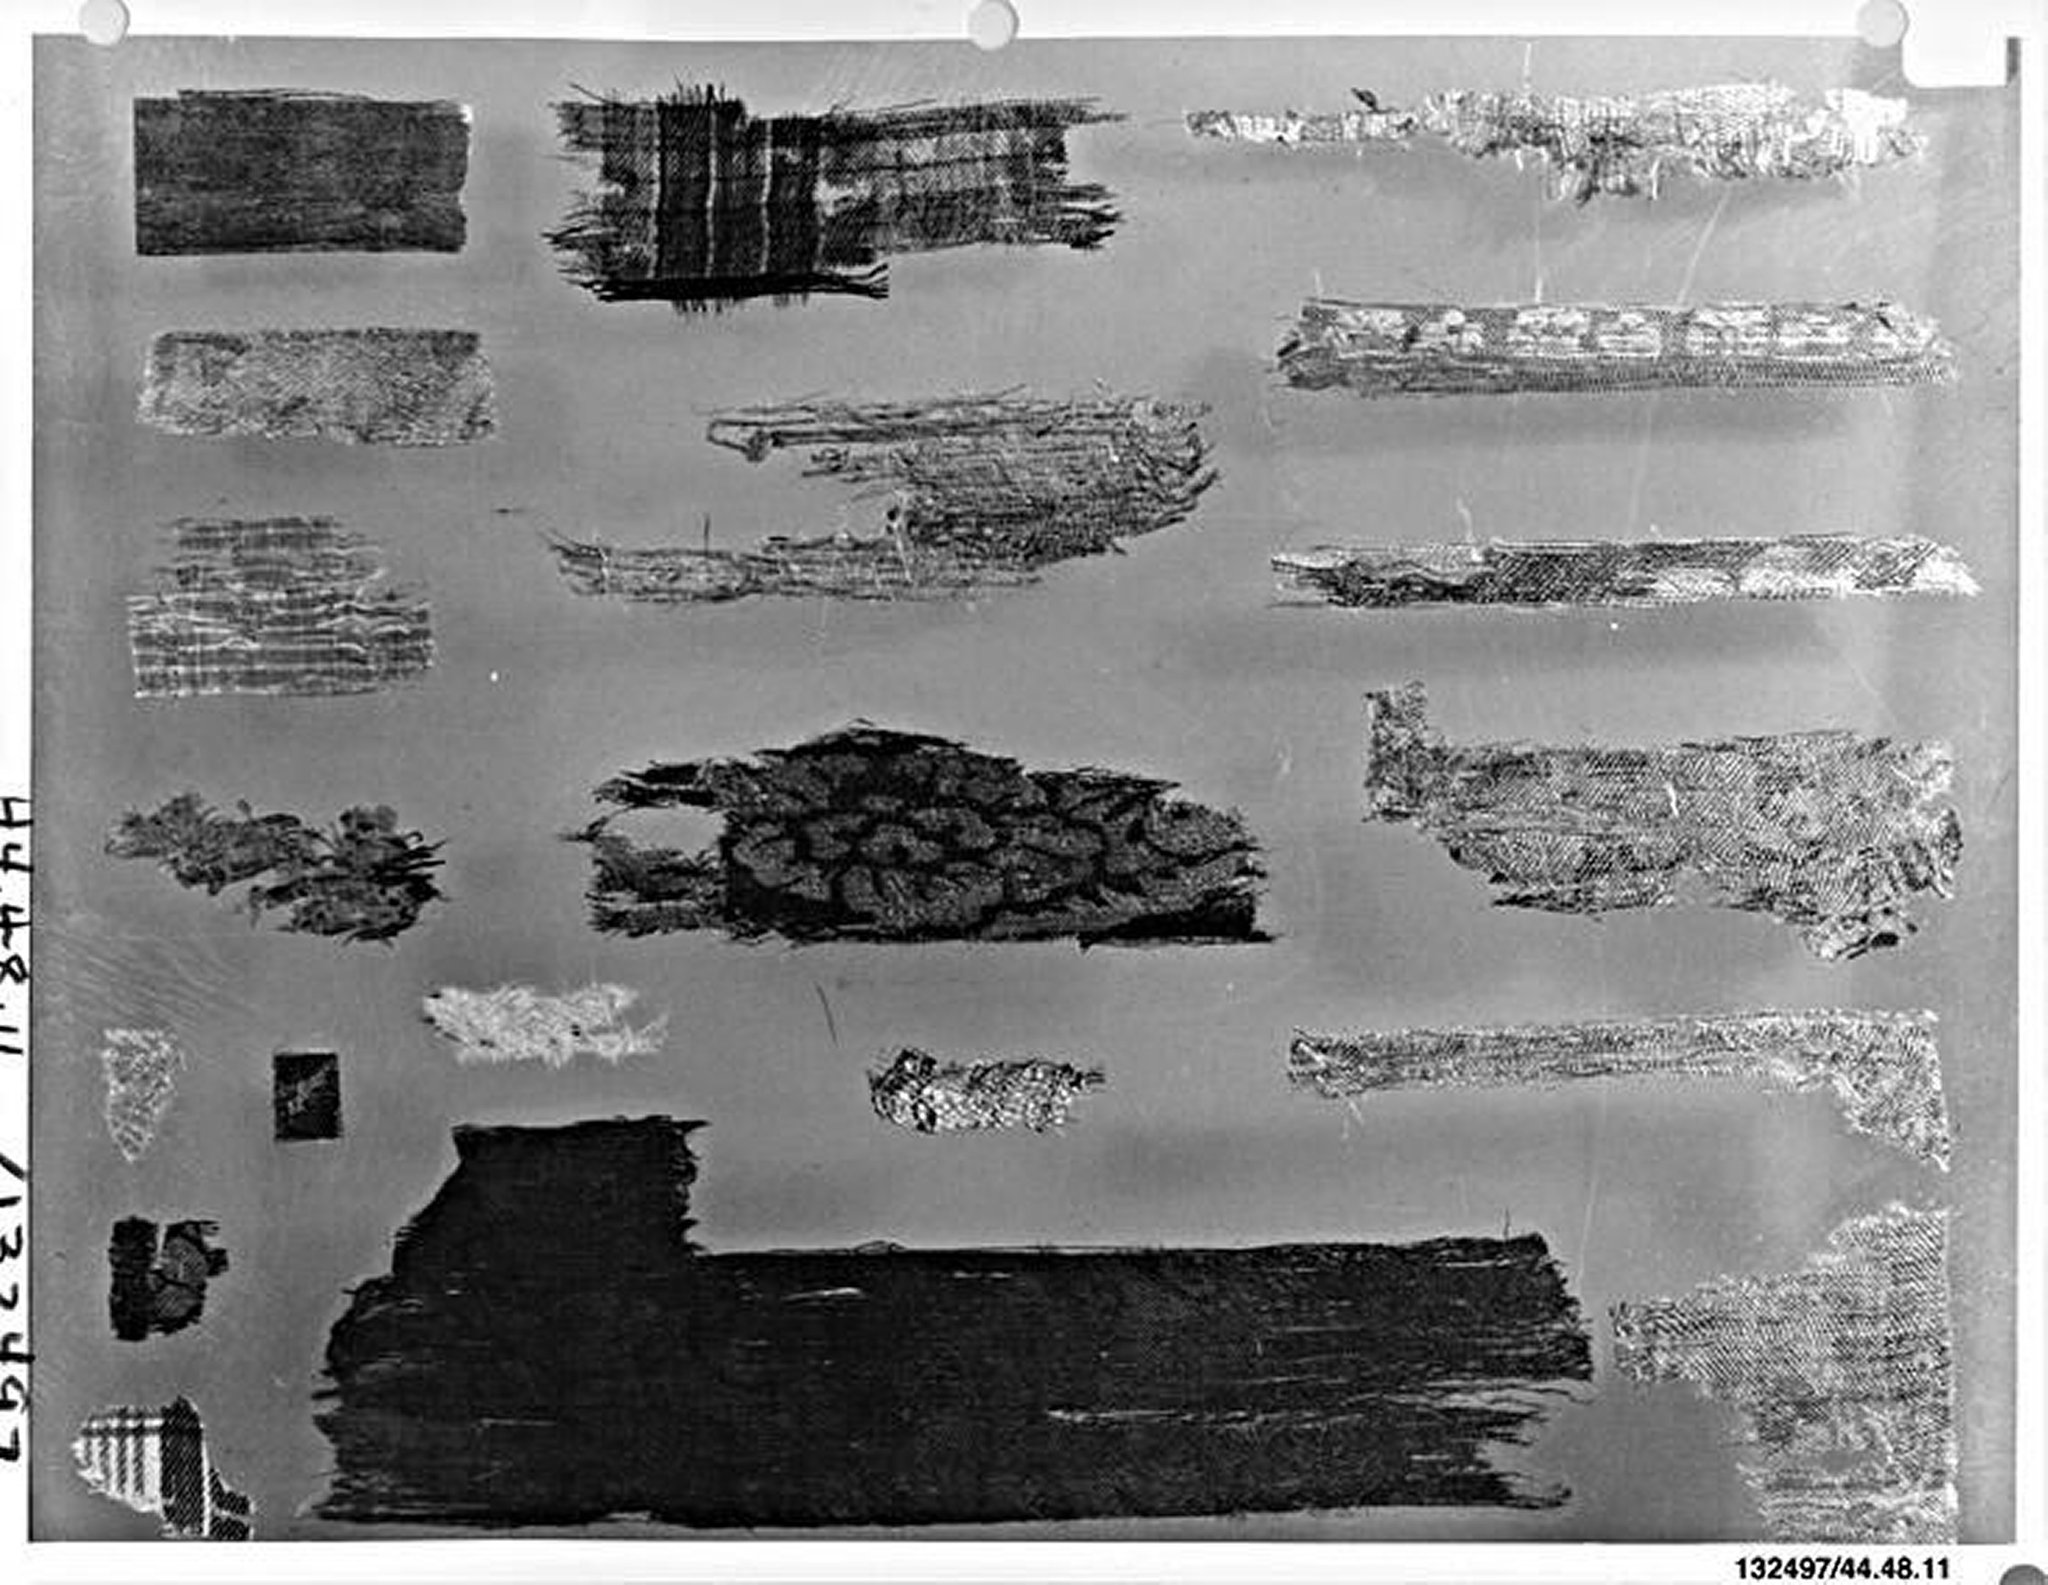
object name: fragment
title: Eighteen Fragments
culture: japanese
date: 701-800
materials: silk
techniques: brocade